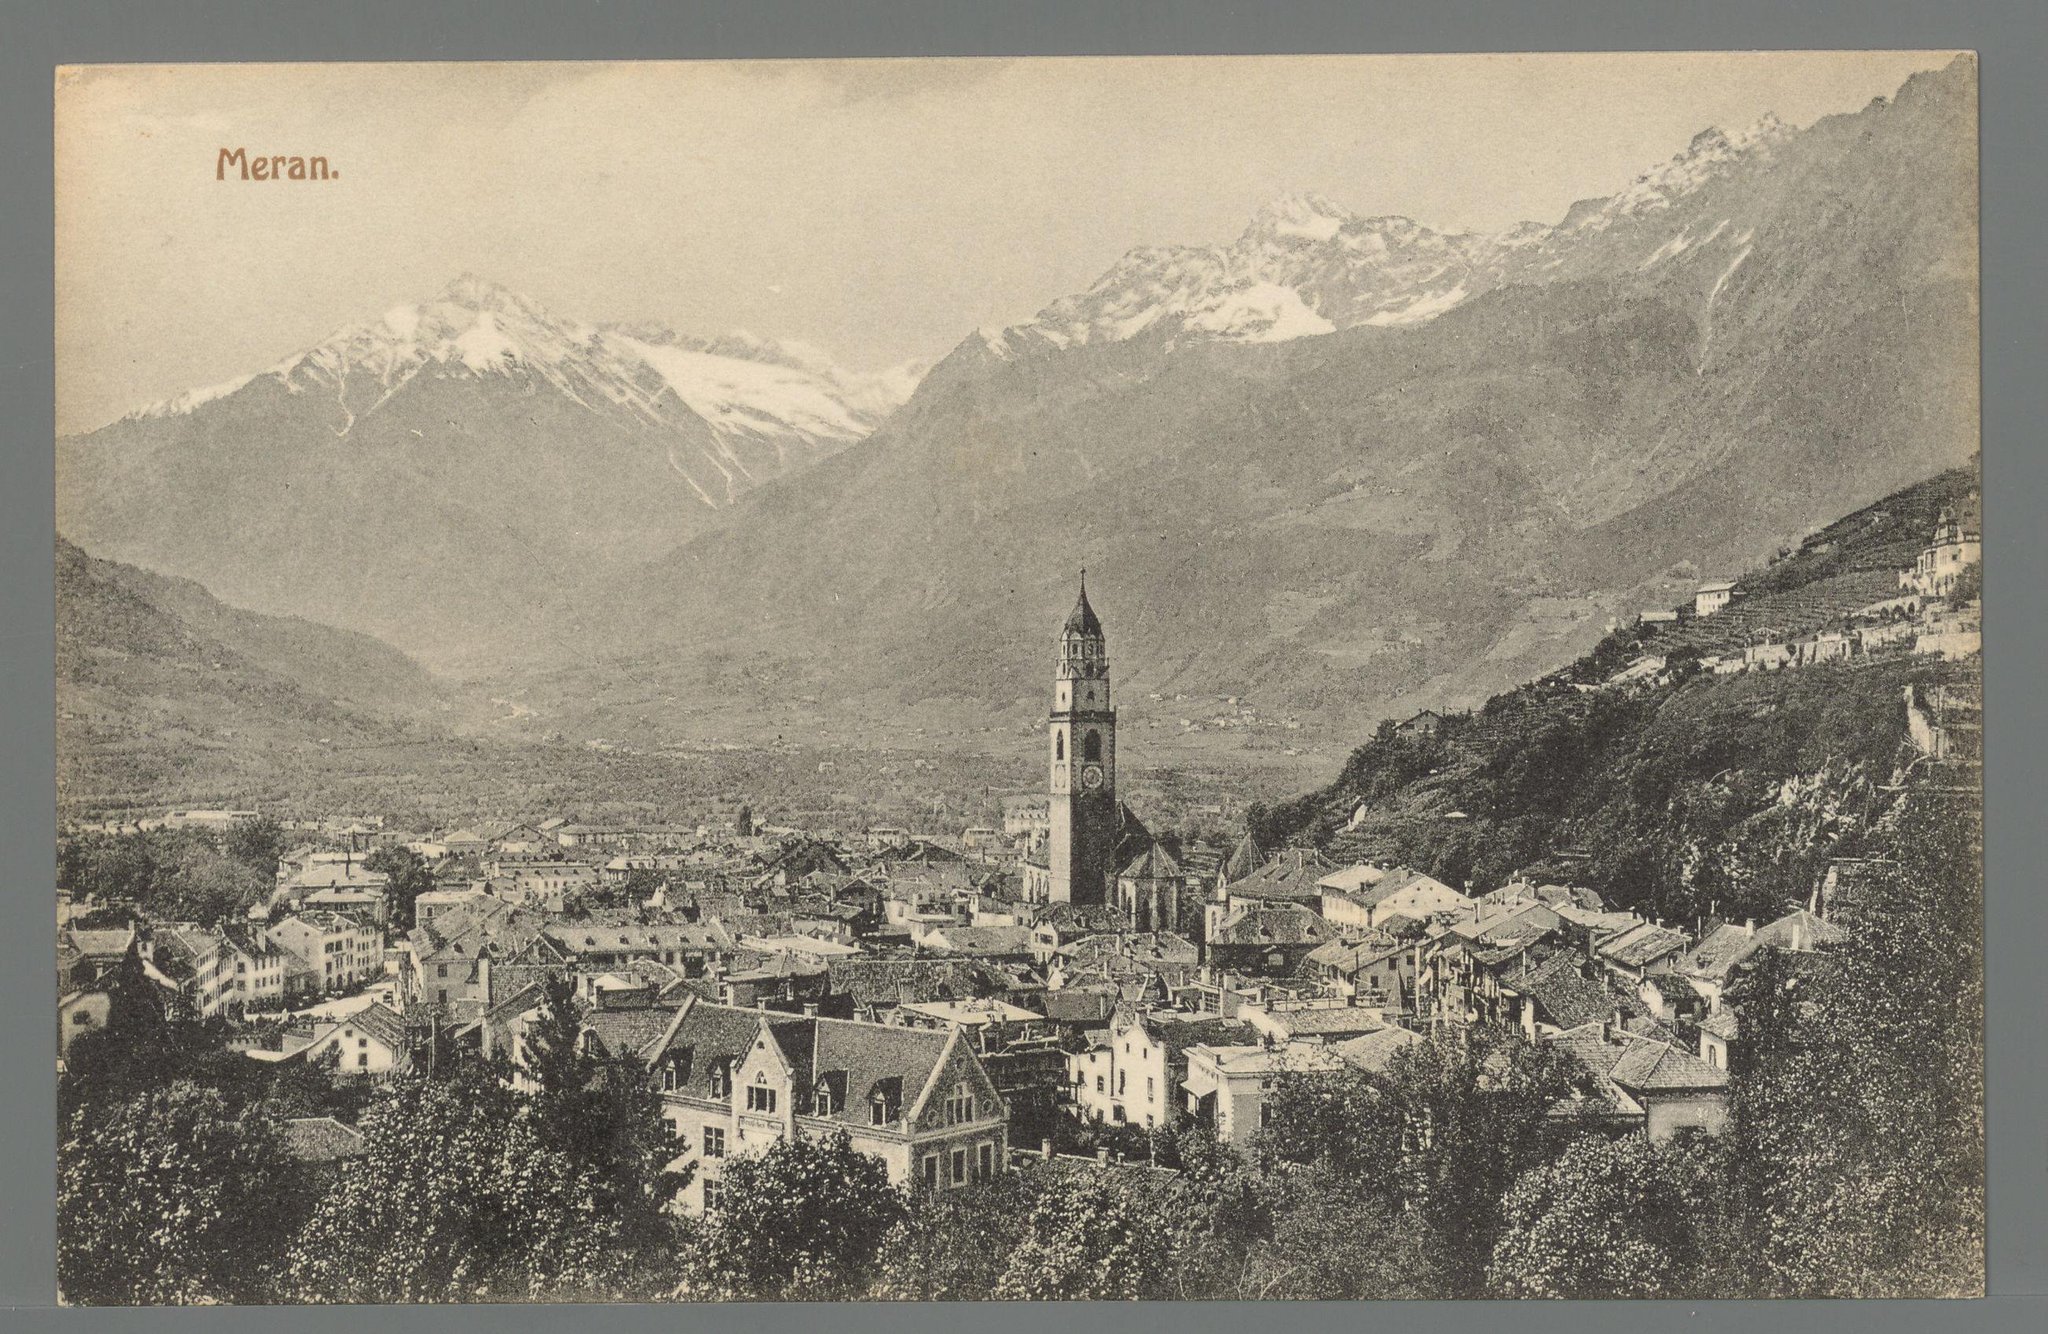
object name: photomechanical print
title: Meran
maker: Anonymous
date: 1907-1915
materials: cardboard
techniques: photograph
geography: merano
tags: village, church (exterior), mountains